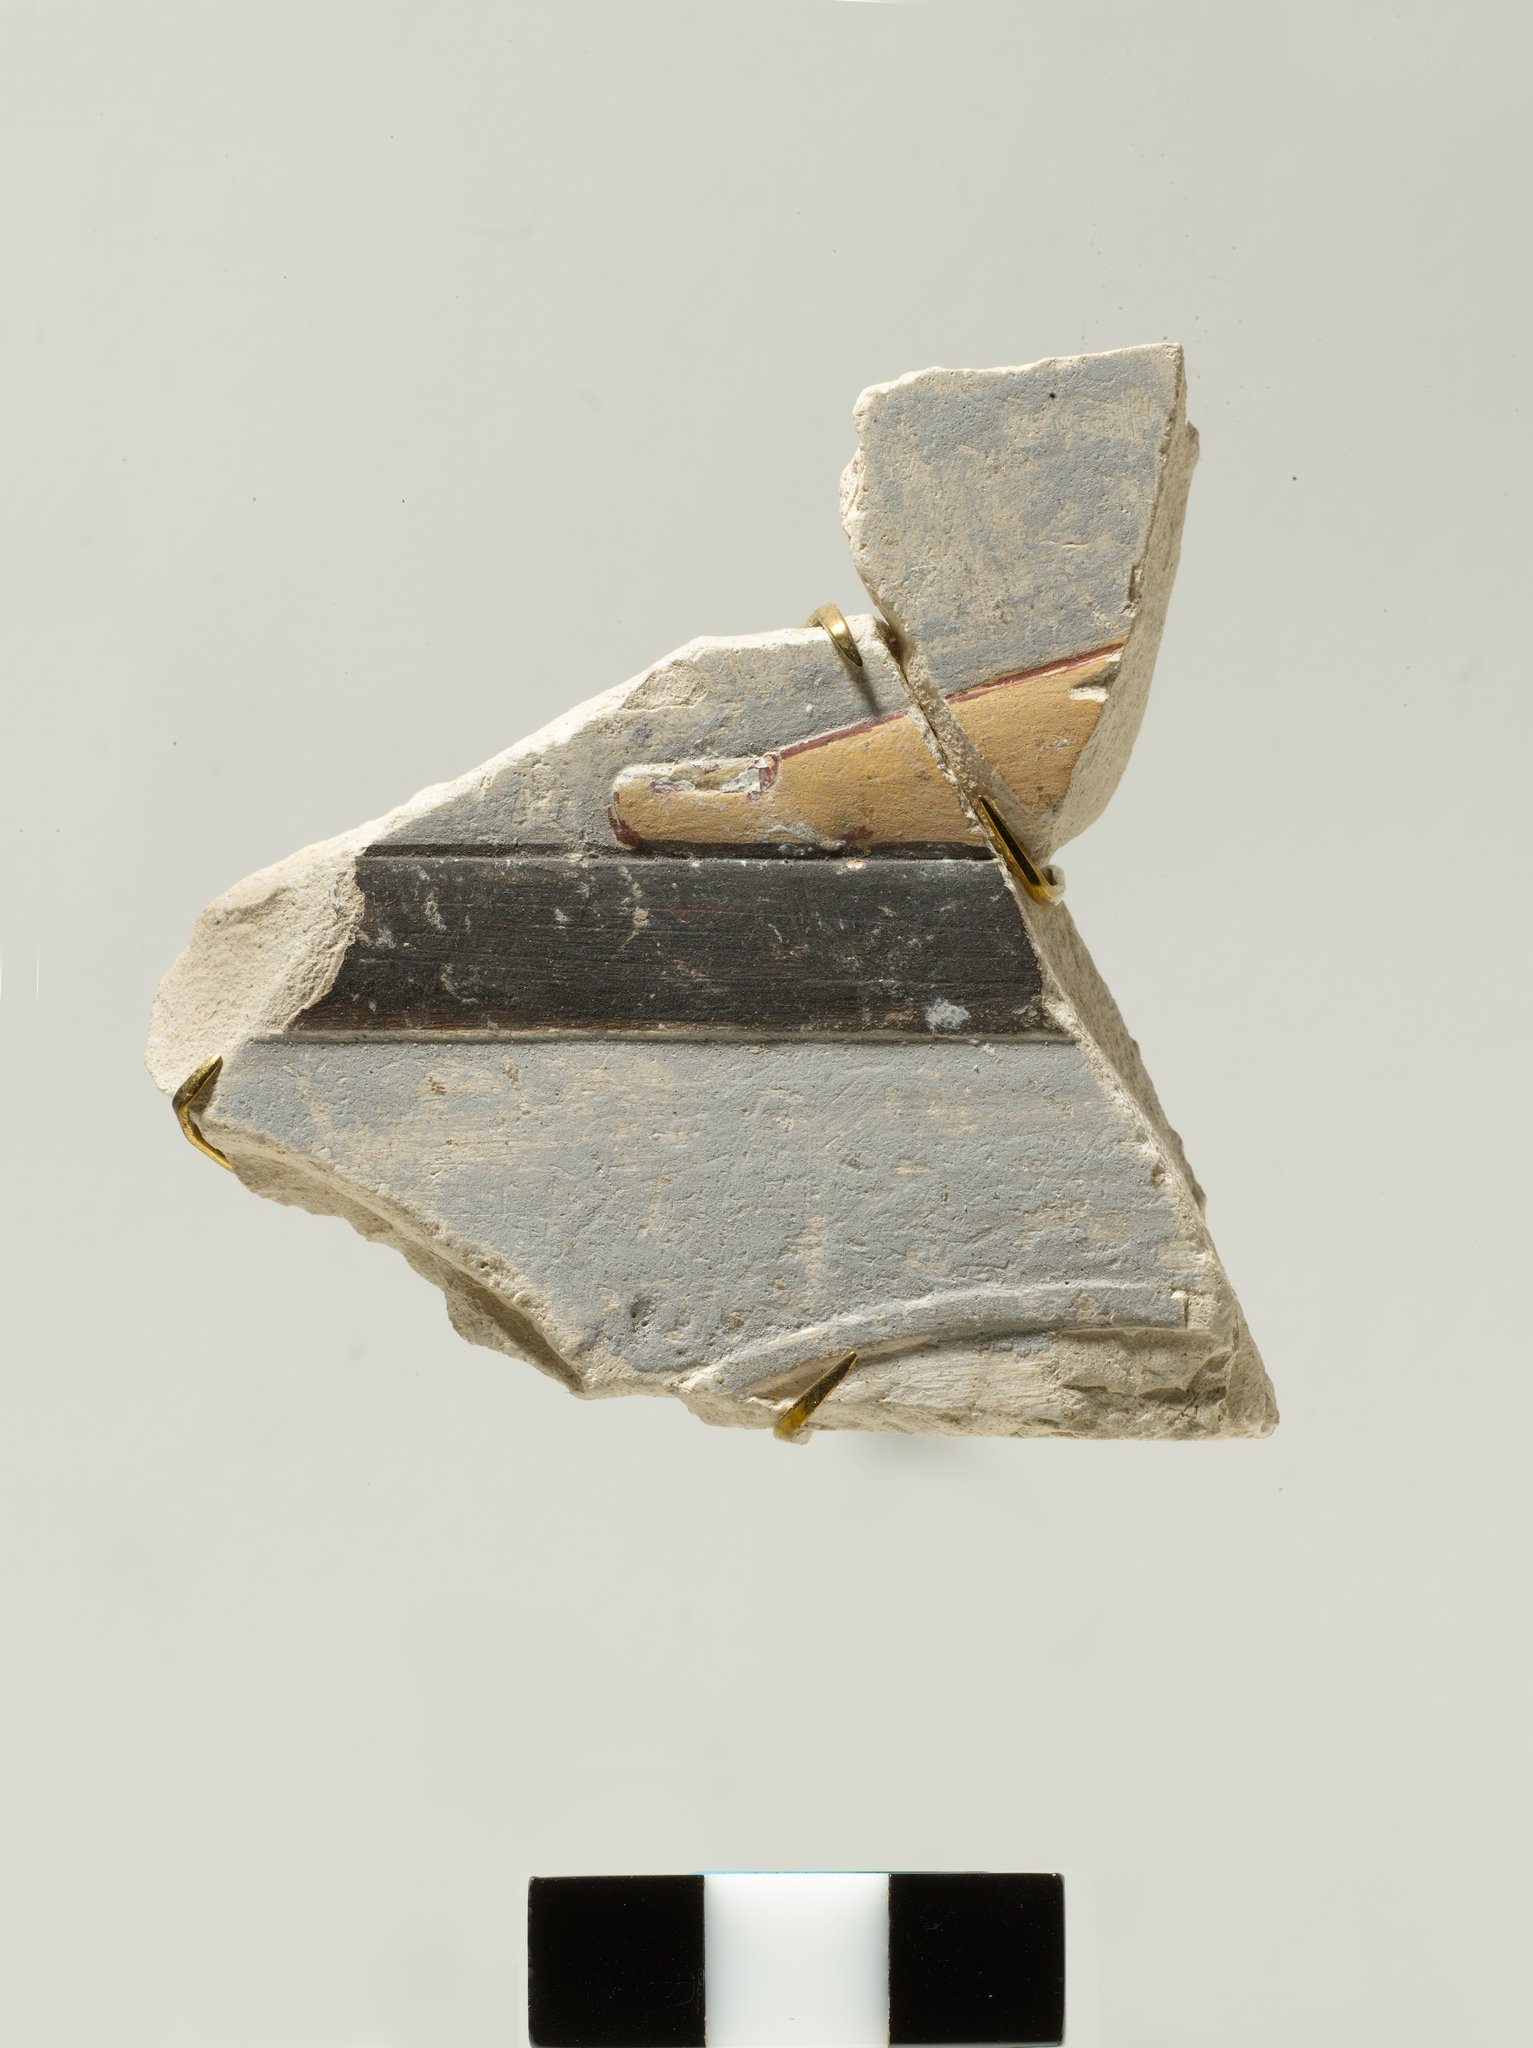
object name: relief fragment, tomb of meketre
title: Reliefs from the tomb of Meketre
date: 1981-1975 BCE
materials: limestone, paint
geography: egypt